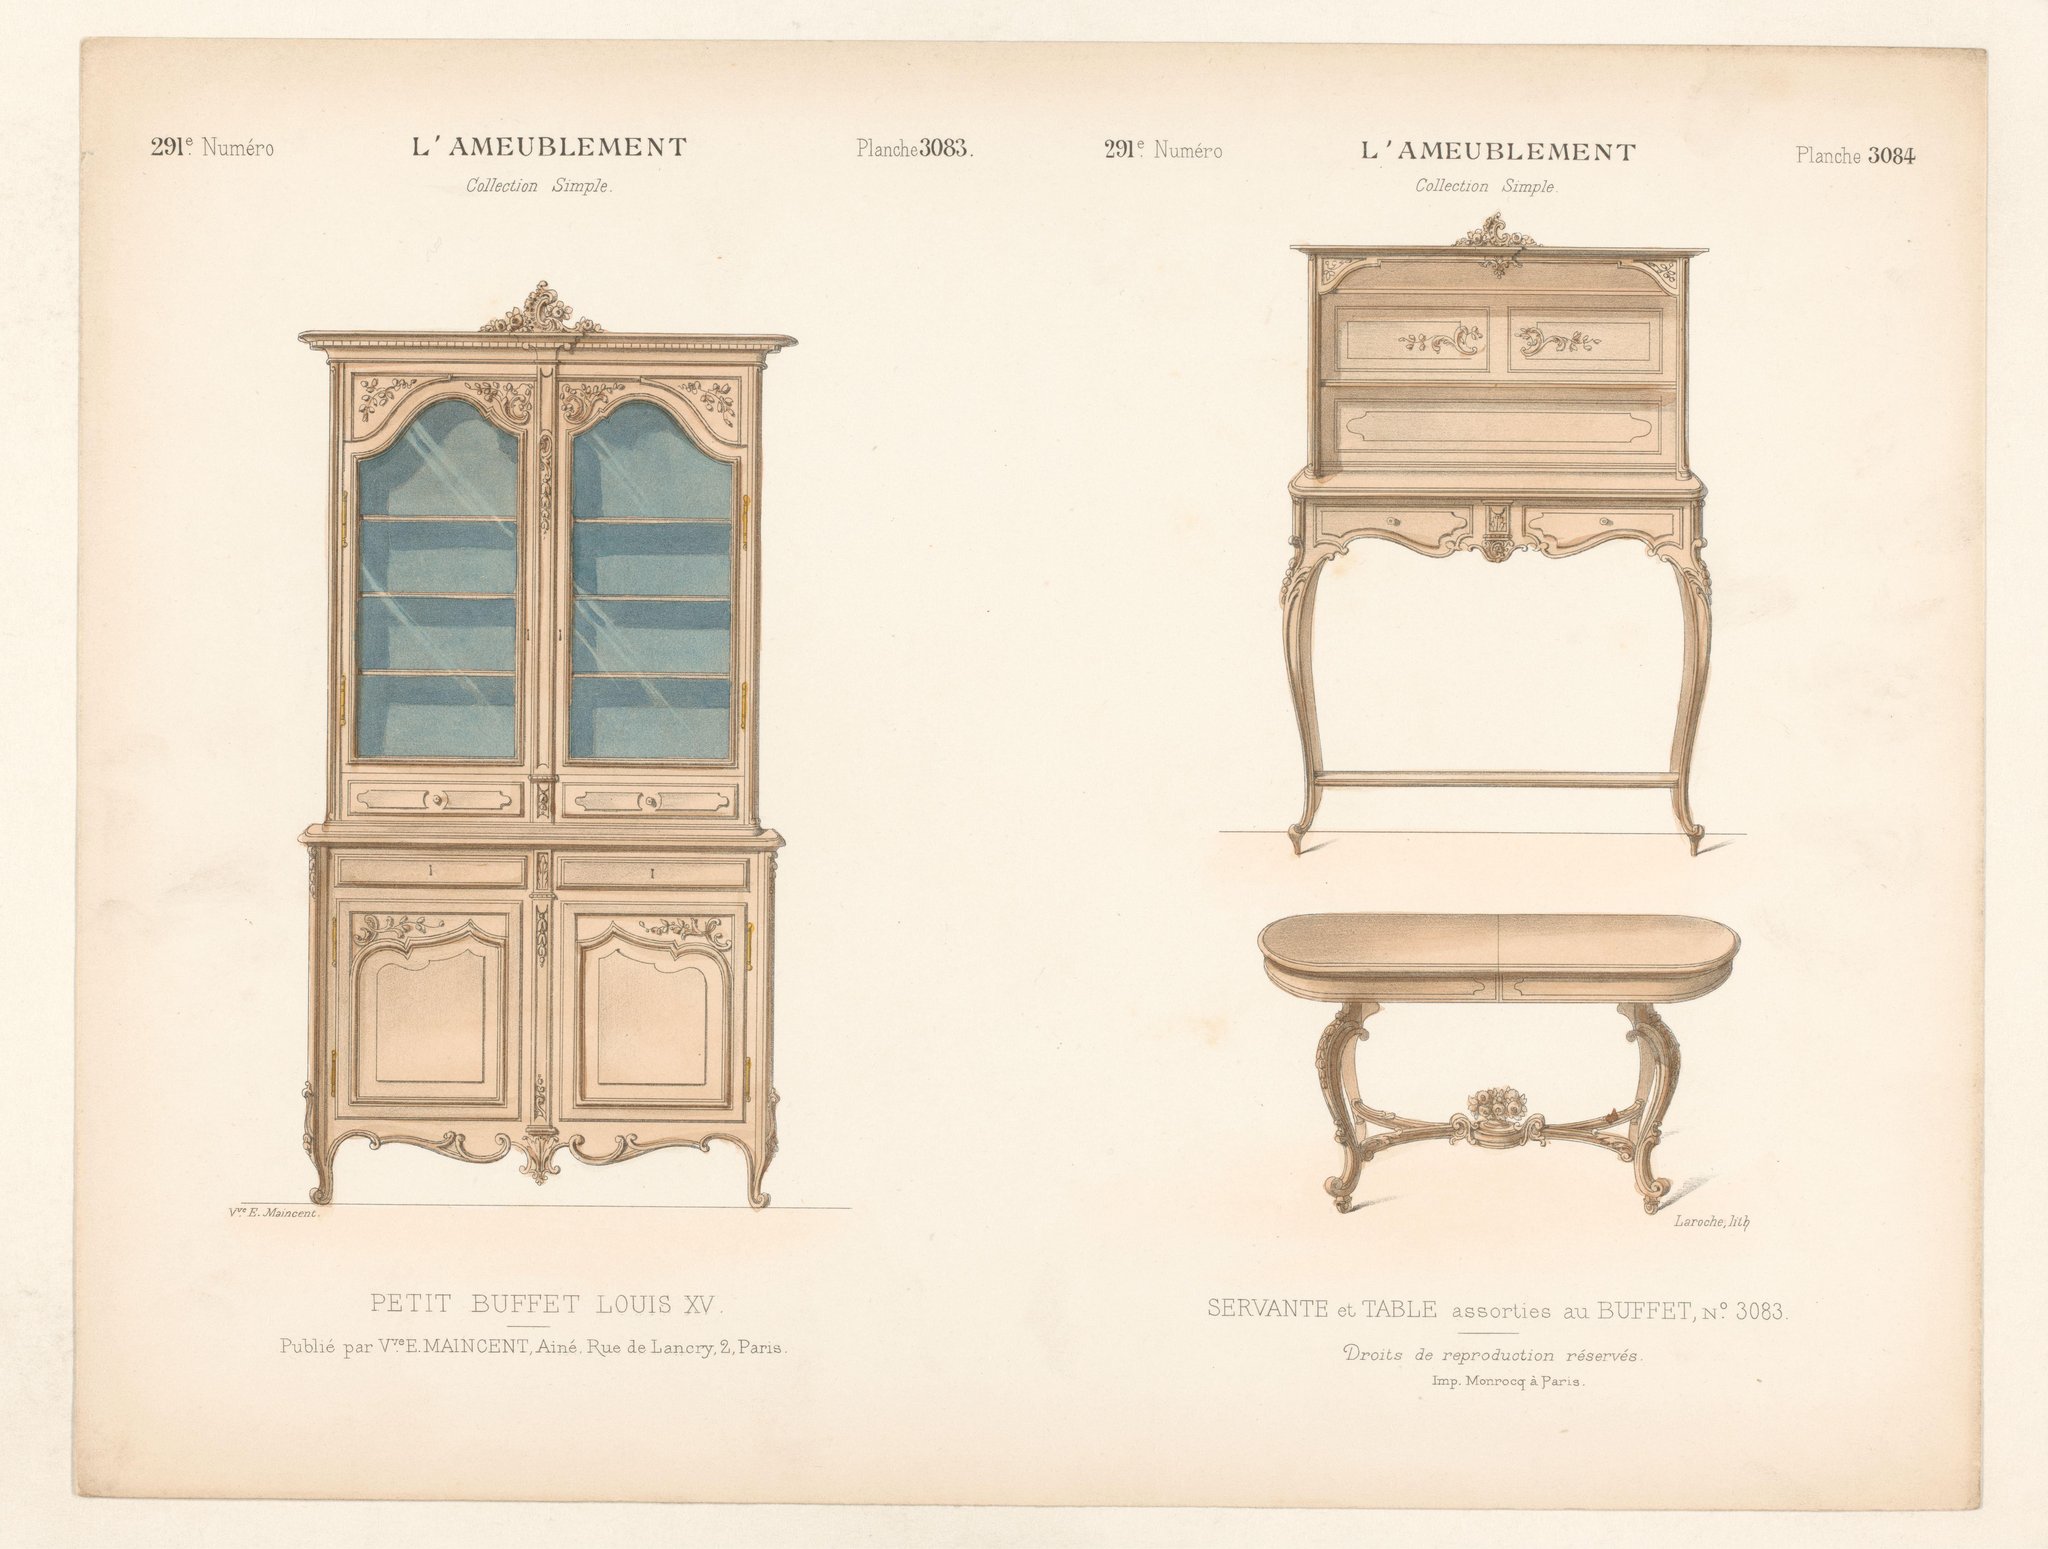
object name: print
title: Buffetkast, kast en tafel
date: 1895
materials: paper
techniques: hand coloring, lithograph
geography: paris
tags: furniture for storage, table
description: Een buffetkast, lage kast en ovale tafel in de Lodewijk XV-stijl. Prent uit 291e Livraison.